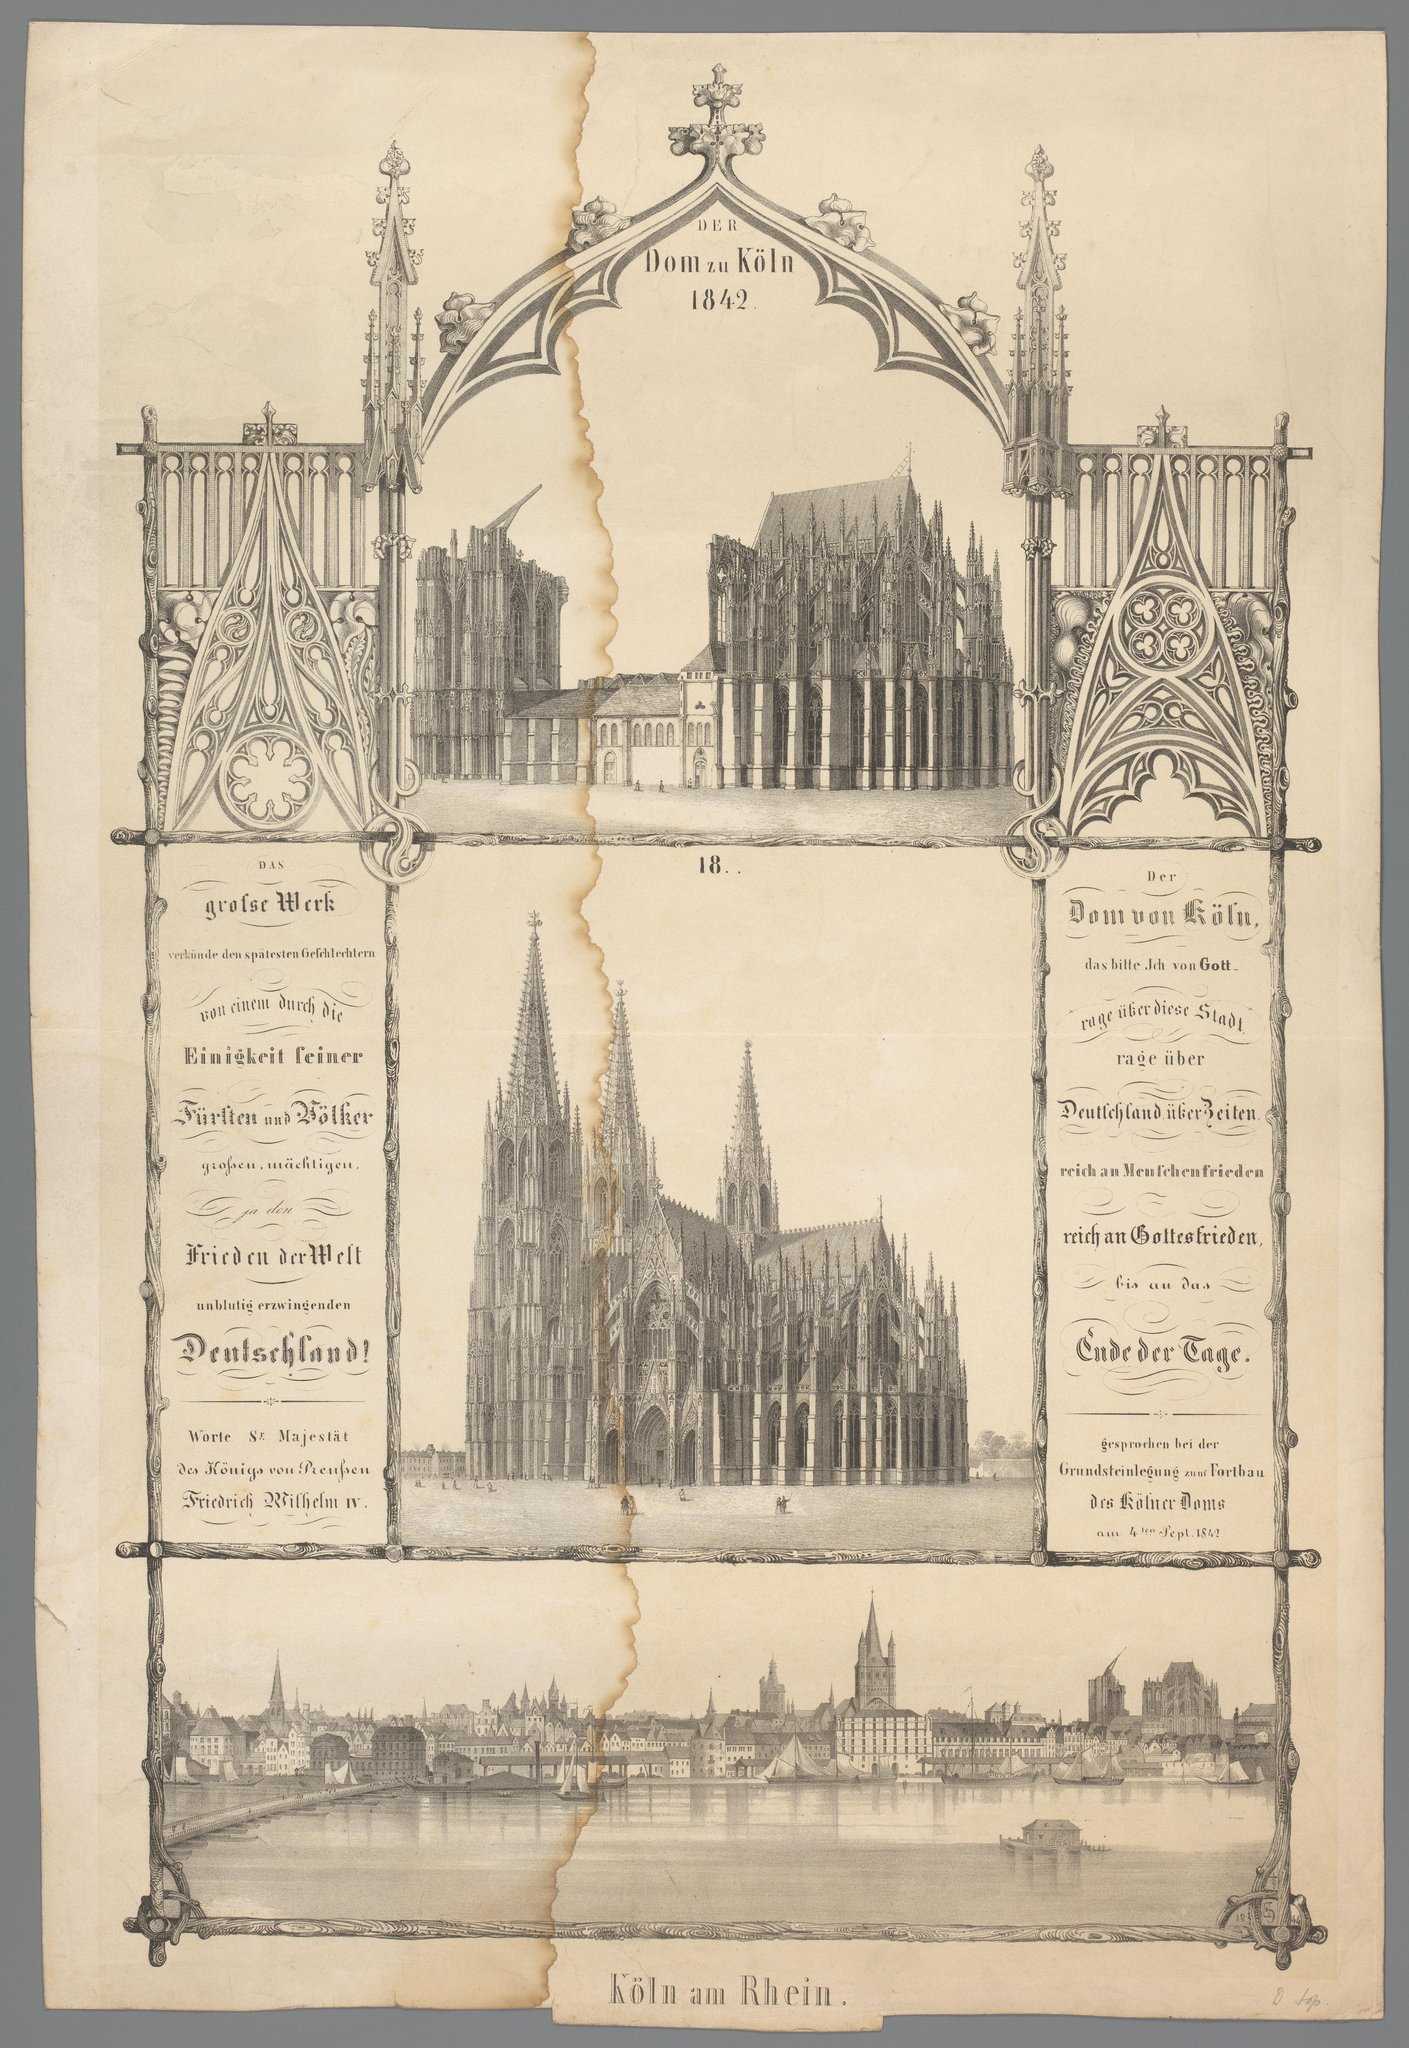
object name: poster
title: Gezicht op de Dom van Keulen in aanbouw, voltooid en gezien vanaf de overzijde van de Rijn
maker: monogrammist cb (19e eeuw)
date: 1844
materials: paper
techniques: lithograph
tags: city-view in general; 'veduta', church (exterior)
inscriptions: date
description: Drie afbeeldingen in een kader van Gotische architectonische elementen en randen als boomtakken: bovenaan de Dom van Keulen voor de voltooiing ('Der Dom zu Köln 1842'). Daaronder een voorstelling van het voltooide gebouw ('18..'). Onderaan een gezicht op de stad Keulen vanaf de Rijn ('Köln am Rhein'). Links en richt van de middelste afbeelding teksten: 'Das grosse Werk verk:unde den spätesten Geschlechtern von einem durch die Einigkeit seiner Fürsten und Völker grossen, mächtigen, ja den Frieden der Welt unblutig erzwingenden Deutschland! Wörte Sr. Majestät des Königs von Preussen Friedrich Wilhelm IV', en: 'Der Dom von Köln, dat bitte Ich von Gott rage über diese Stadt, rage über Deutschland über Zeiten, reich an Menschen frieden reich an Gottes frieden, bus an das Ende der Tage. Gesprochen bei der Grundsteinlegung zum Fortbau des Kölner Doms am 4ten Sept. 1842'.